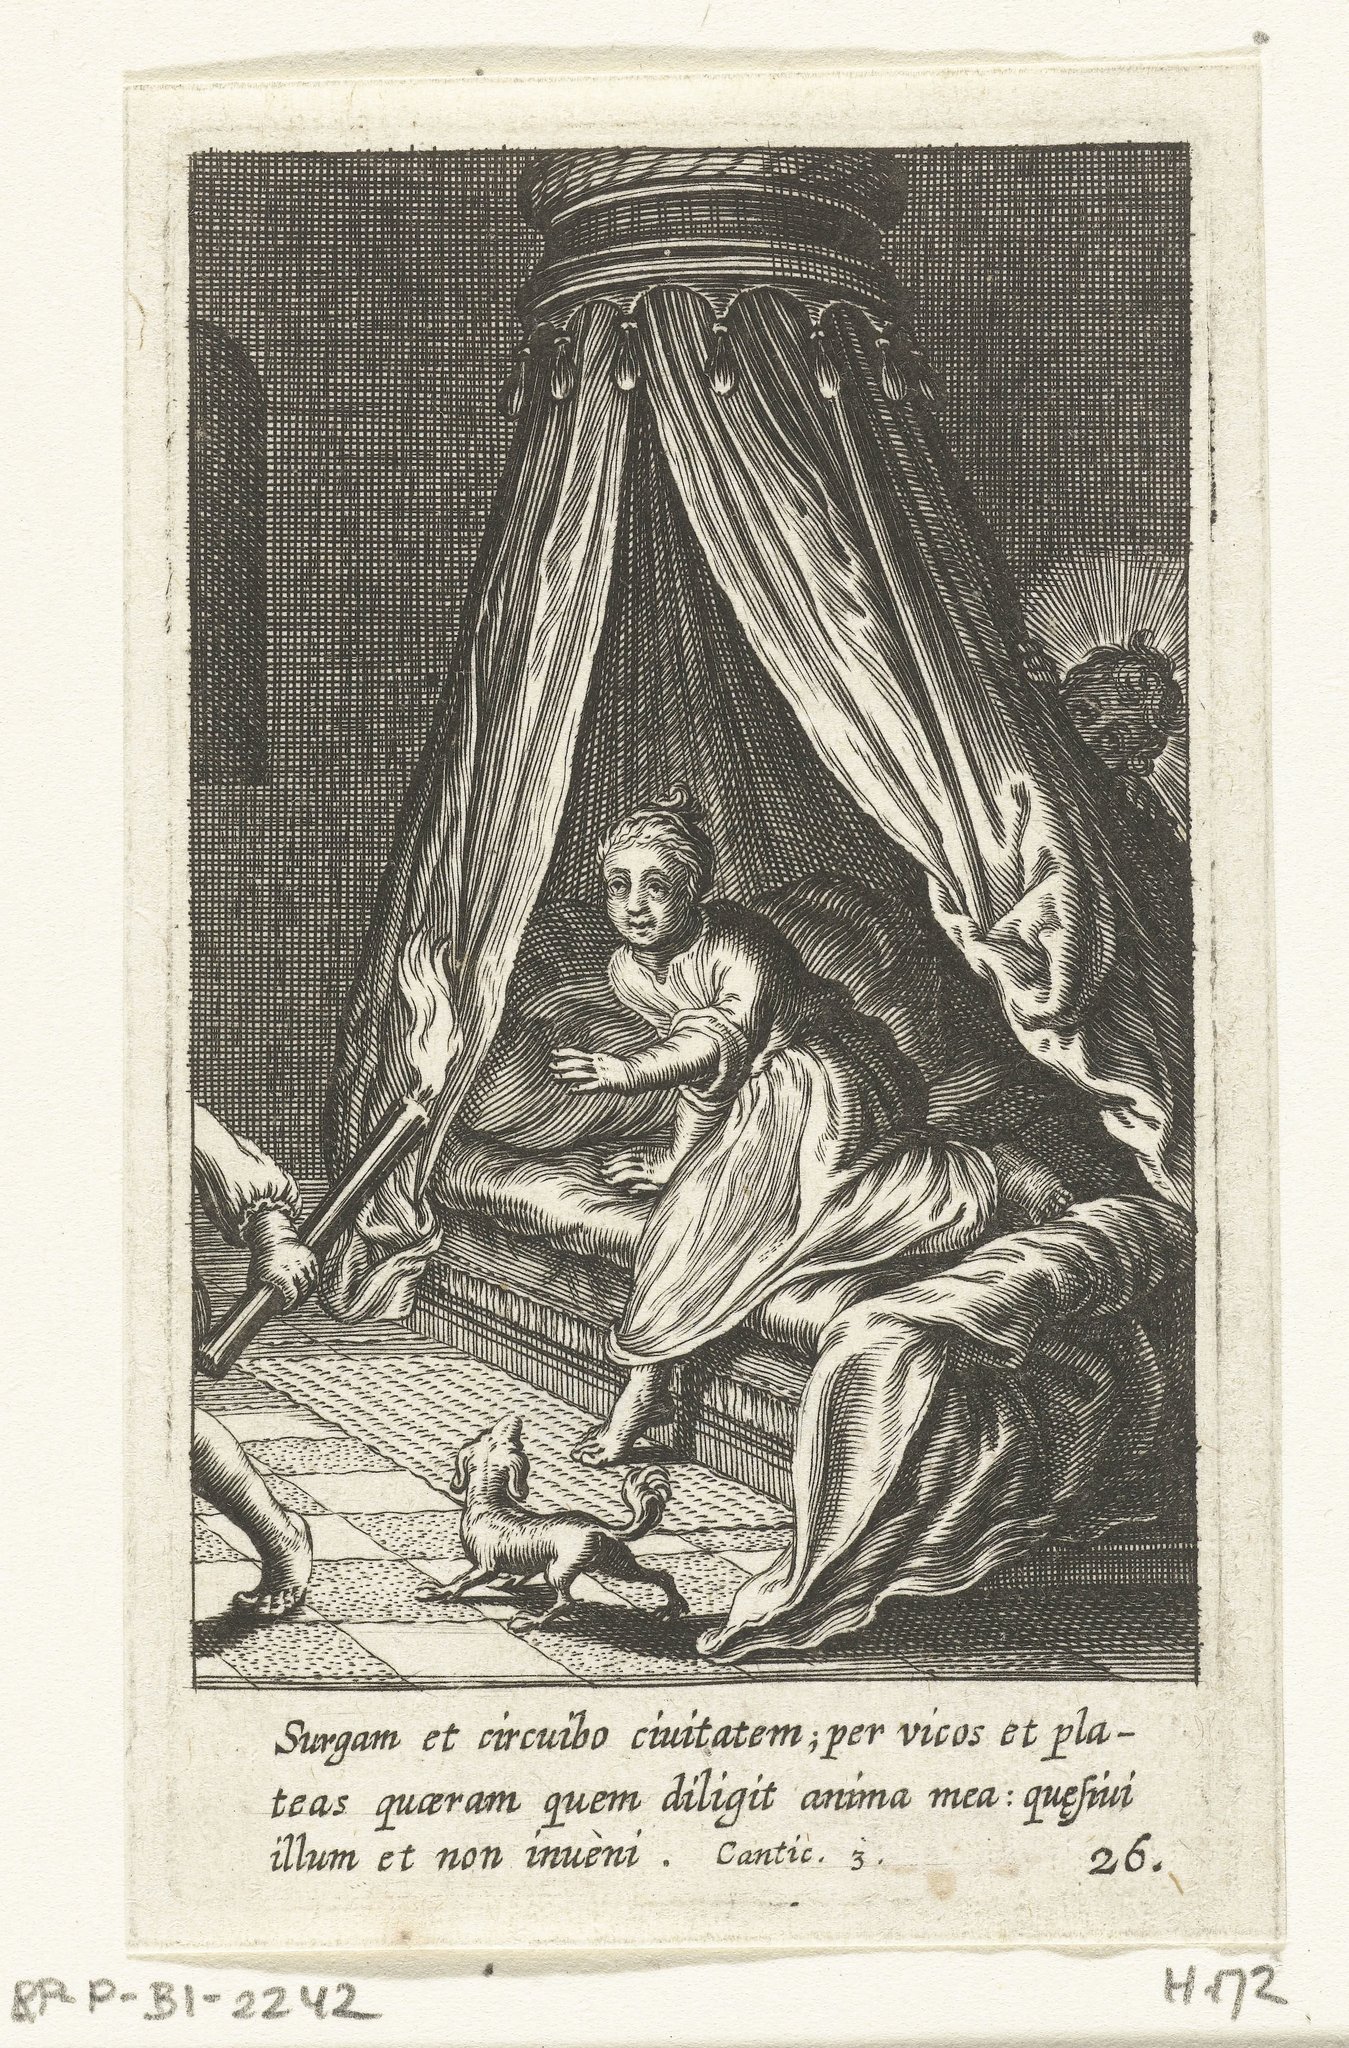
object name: book illustration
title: Kind stapt uit bed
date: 1590-1624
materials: paper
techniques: engraving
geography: antwerp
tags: bed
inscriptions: inscription: ‘Surgam, et circuibo ciuitatem; per vicos et plateas quæram quem diligit anima mea: quæsiui illum, et non inueni.’, collector's mark: Lugt 240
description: Een kind stapt uit bed en volgt een verdwijnende figuur met fakkel. Achter de hemel van het bed gluurt de engel naar deze gebeurtenis.